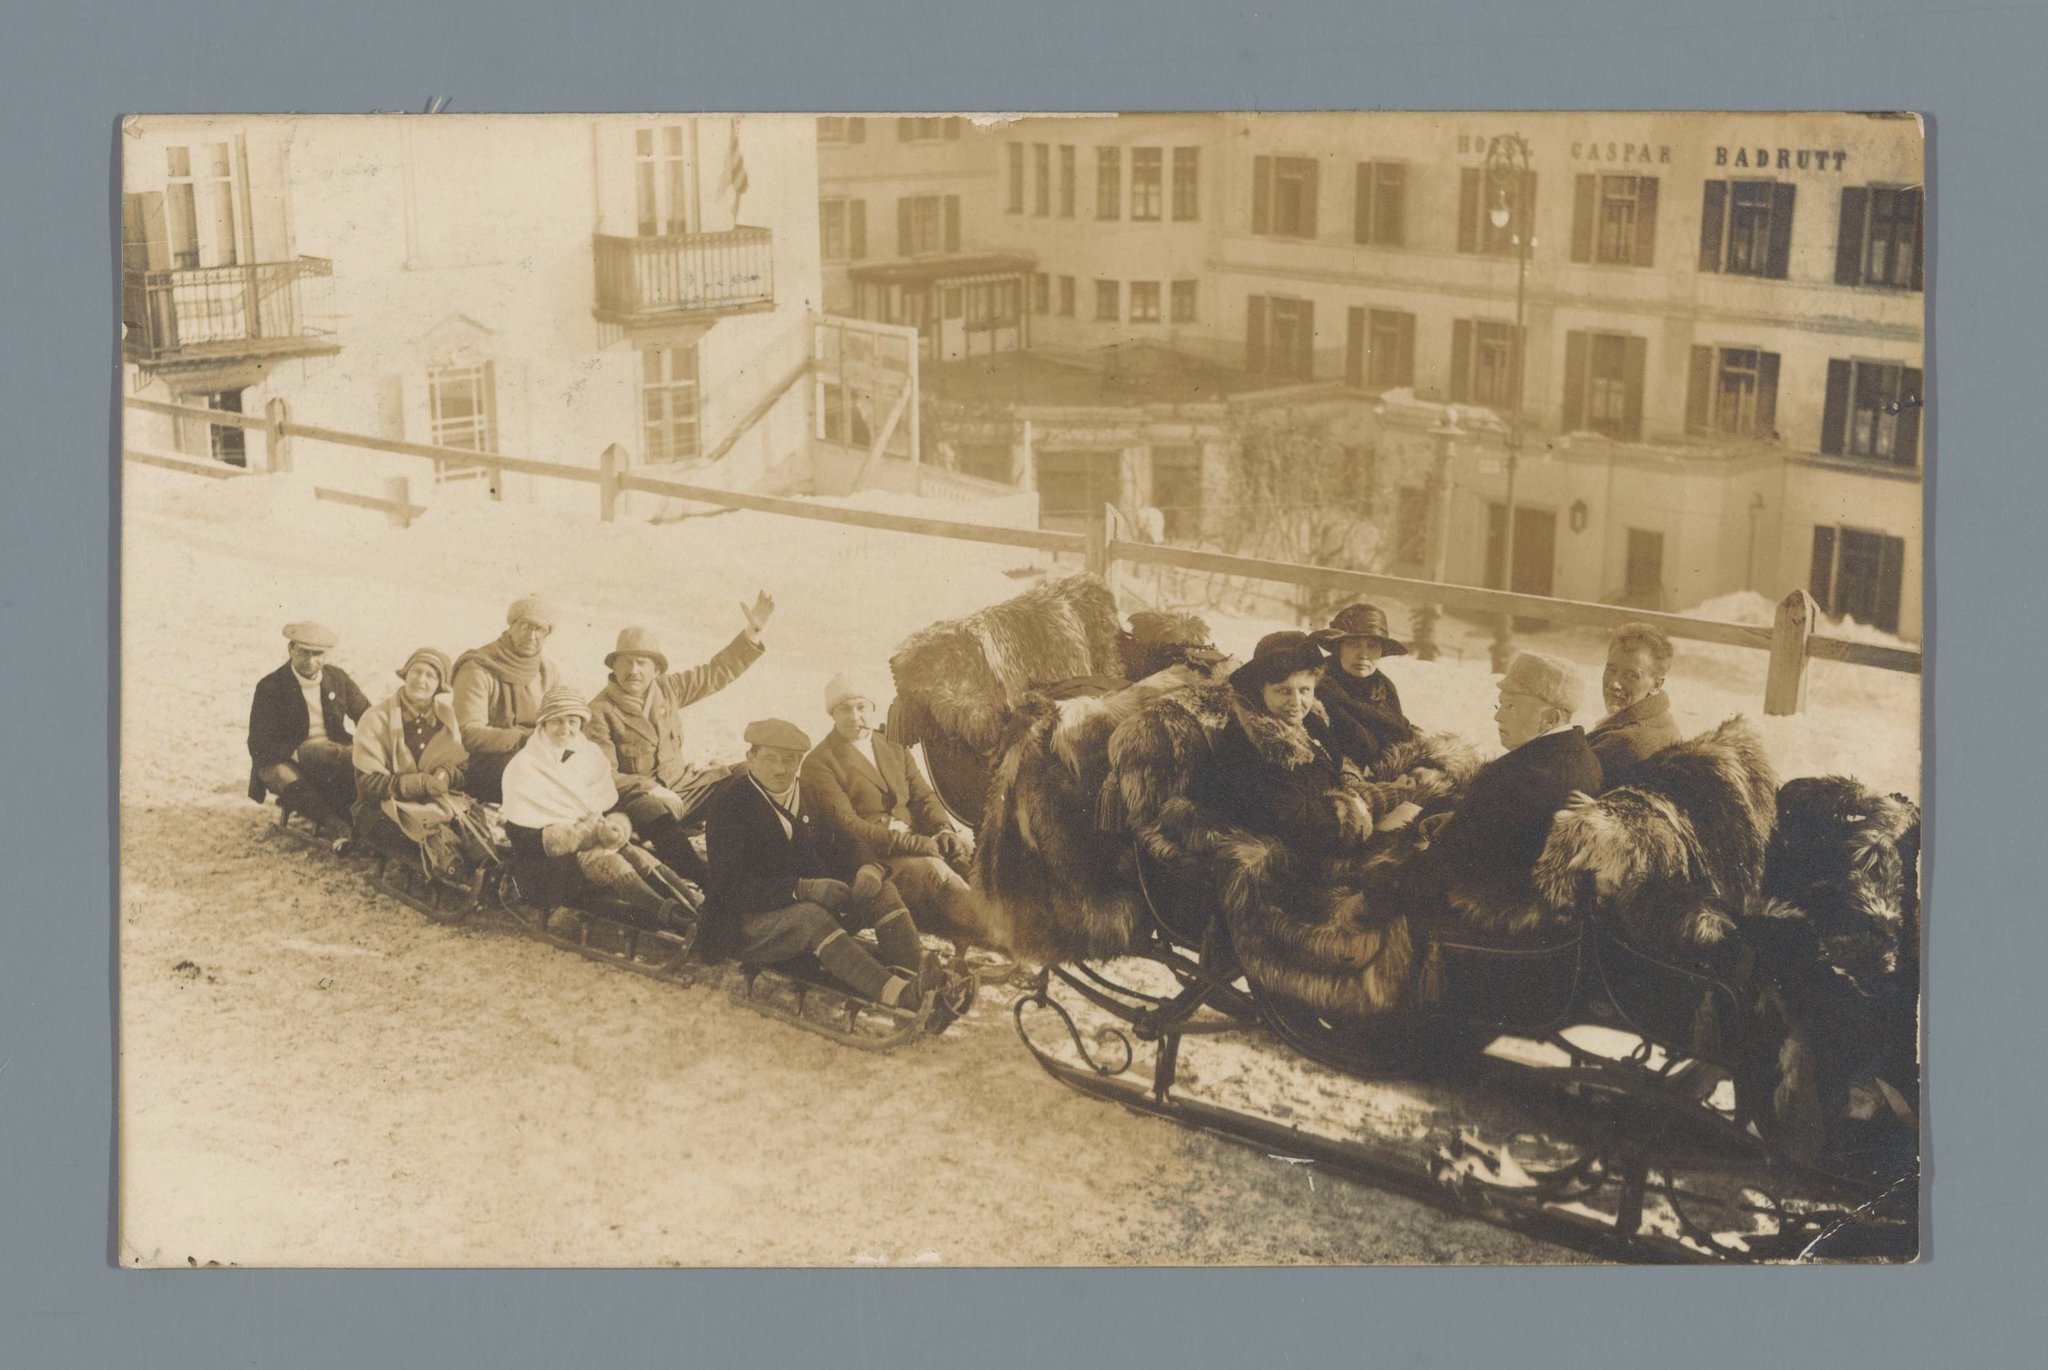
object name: ansichtkaart, prentbriefkaart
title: Zeven onbekende personen op houten sleeën achter een arrenslee (vermoedelijk) te Sankt Moritz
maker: Anonymous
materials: photographic support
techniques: gelatin silver print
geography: sankt moritz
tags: sleigh, sledge (non-sport), sledge, sleigh (winter sports)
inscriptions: inscription: ‘s Haag. 21 Feb, '23. (...) Oegstgeest bij Leiden’